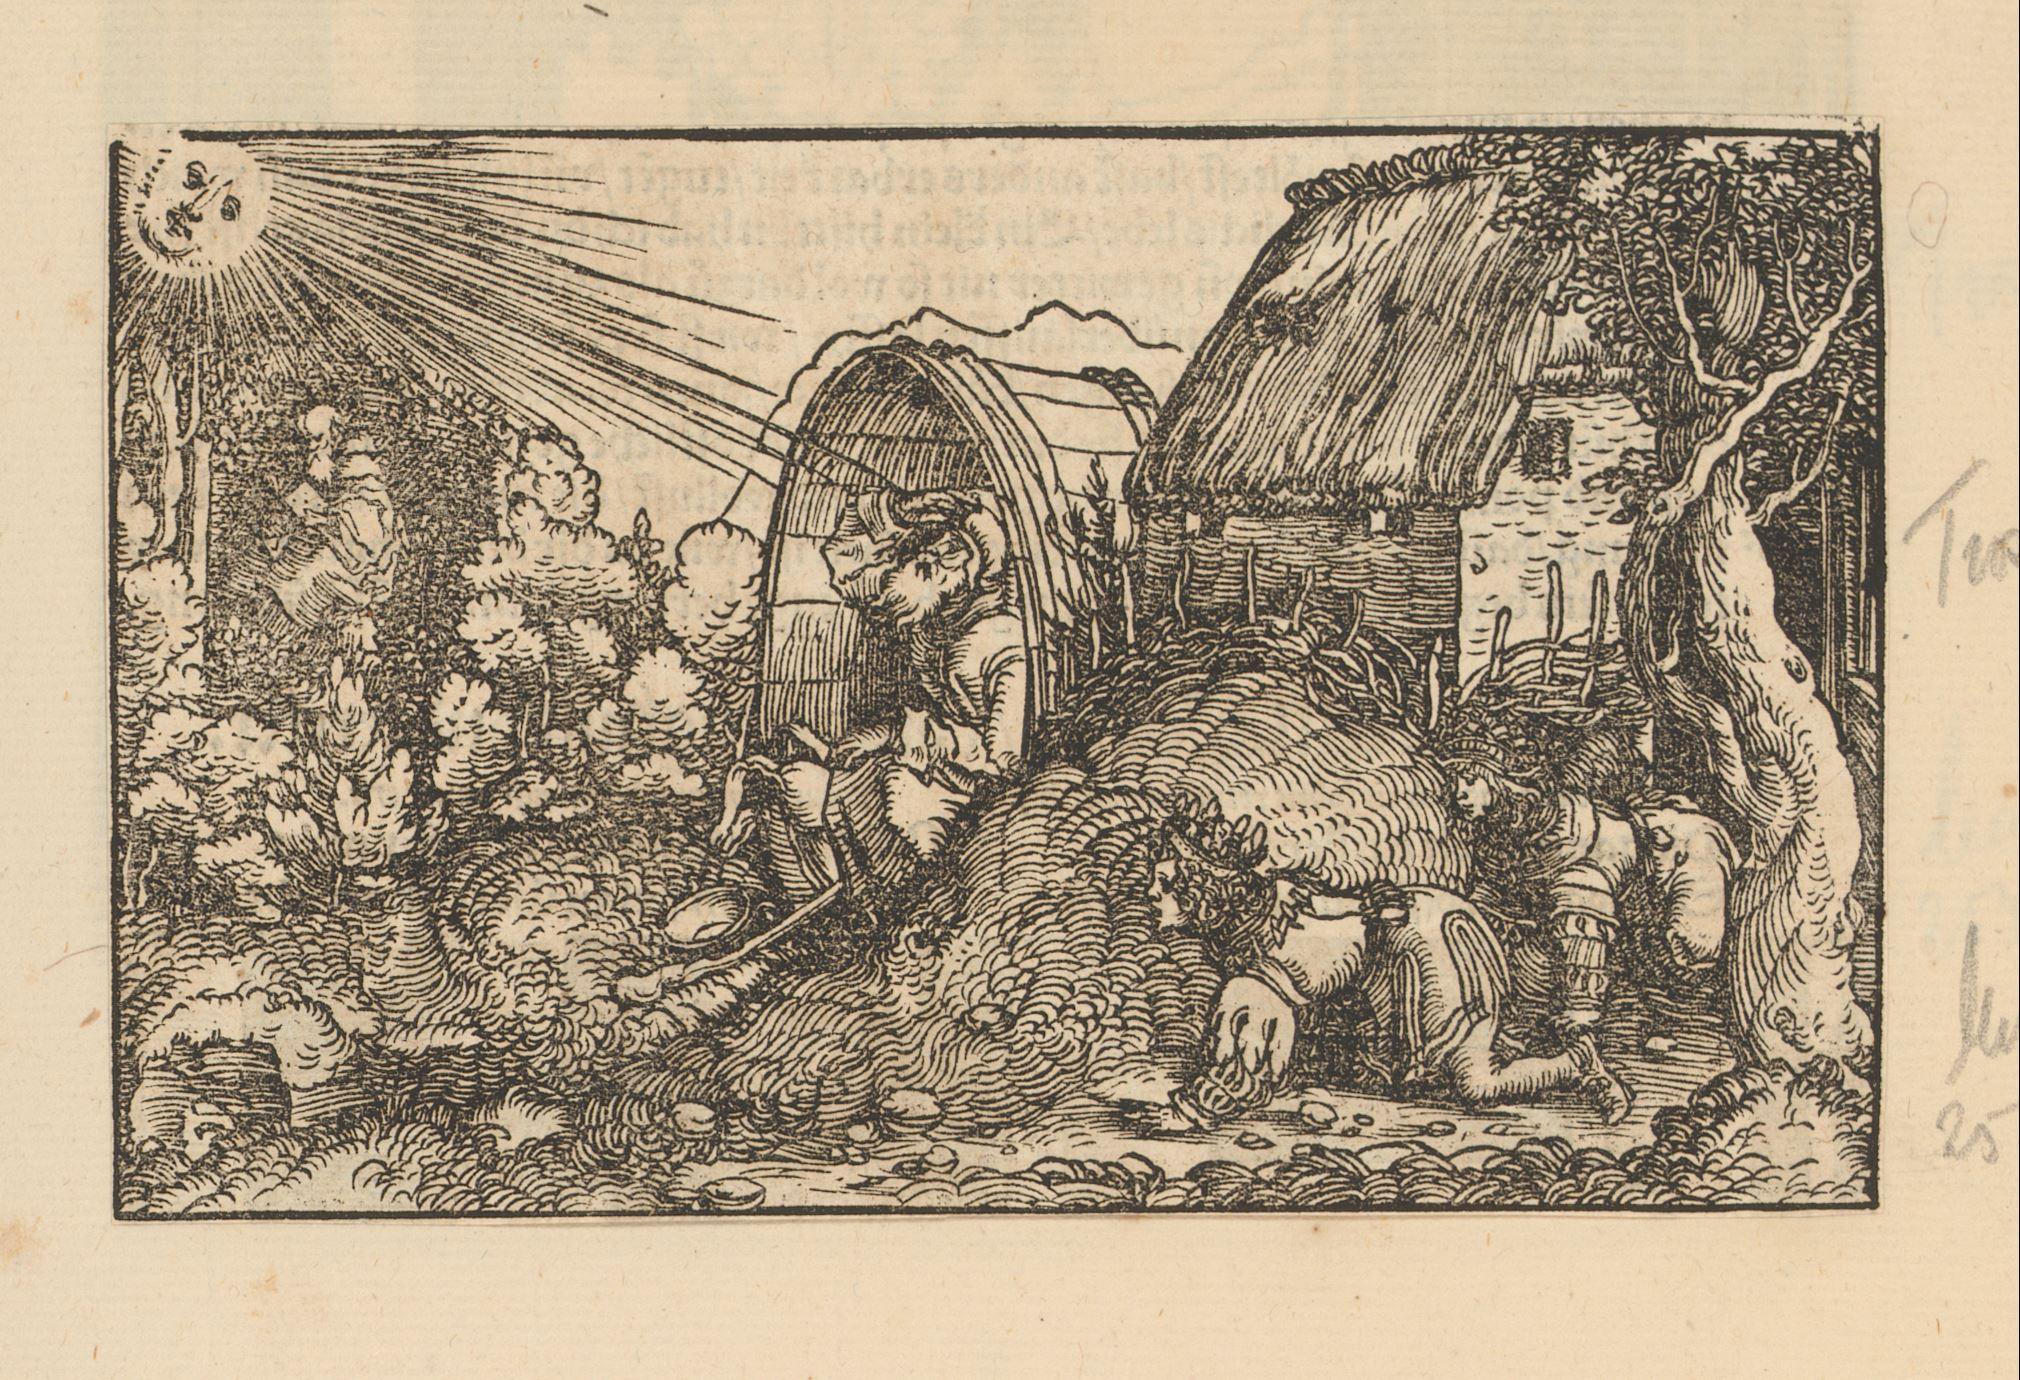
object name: print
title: Diogenes in zijn ton en twee gekroonde jongemannen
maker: Anonymous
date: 1514-1532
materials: paper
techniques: letterpress printing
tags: (story of) diogenes, the philosopher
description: Deze prent is gebruikt in: Petrarca, Francesco. Von der Artzney bayder Glück, des guten und widerwertigen: unnd weß sich ain yeder inn Gelück und Unglück halten sol (...). Augsburg: Heinrich Steiner, 1532. Deze uitgave is ook bekend onder de titel 'Trostspiegel in Glück und Unglück'.